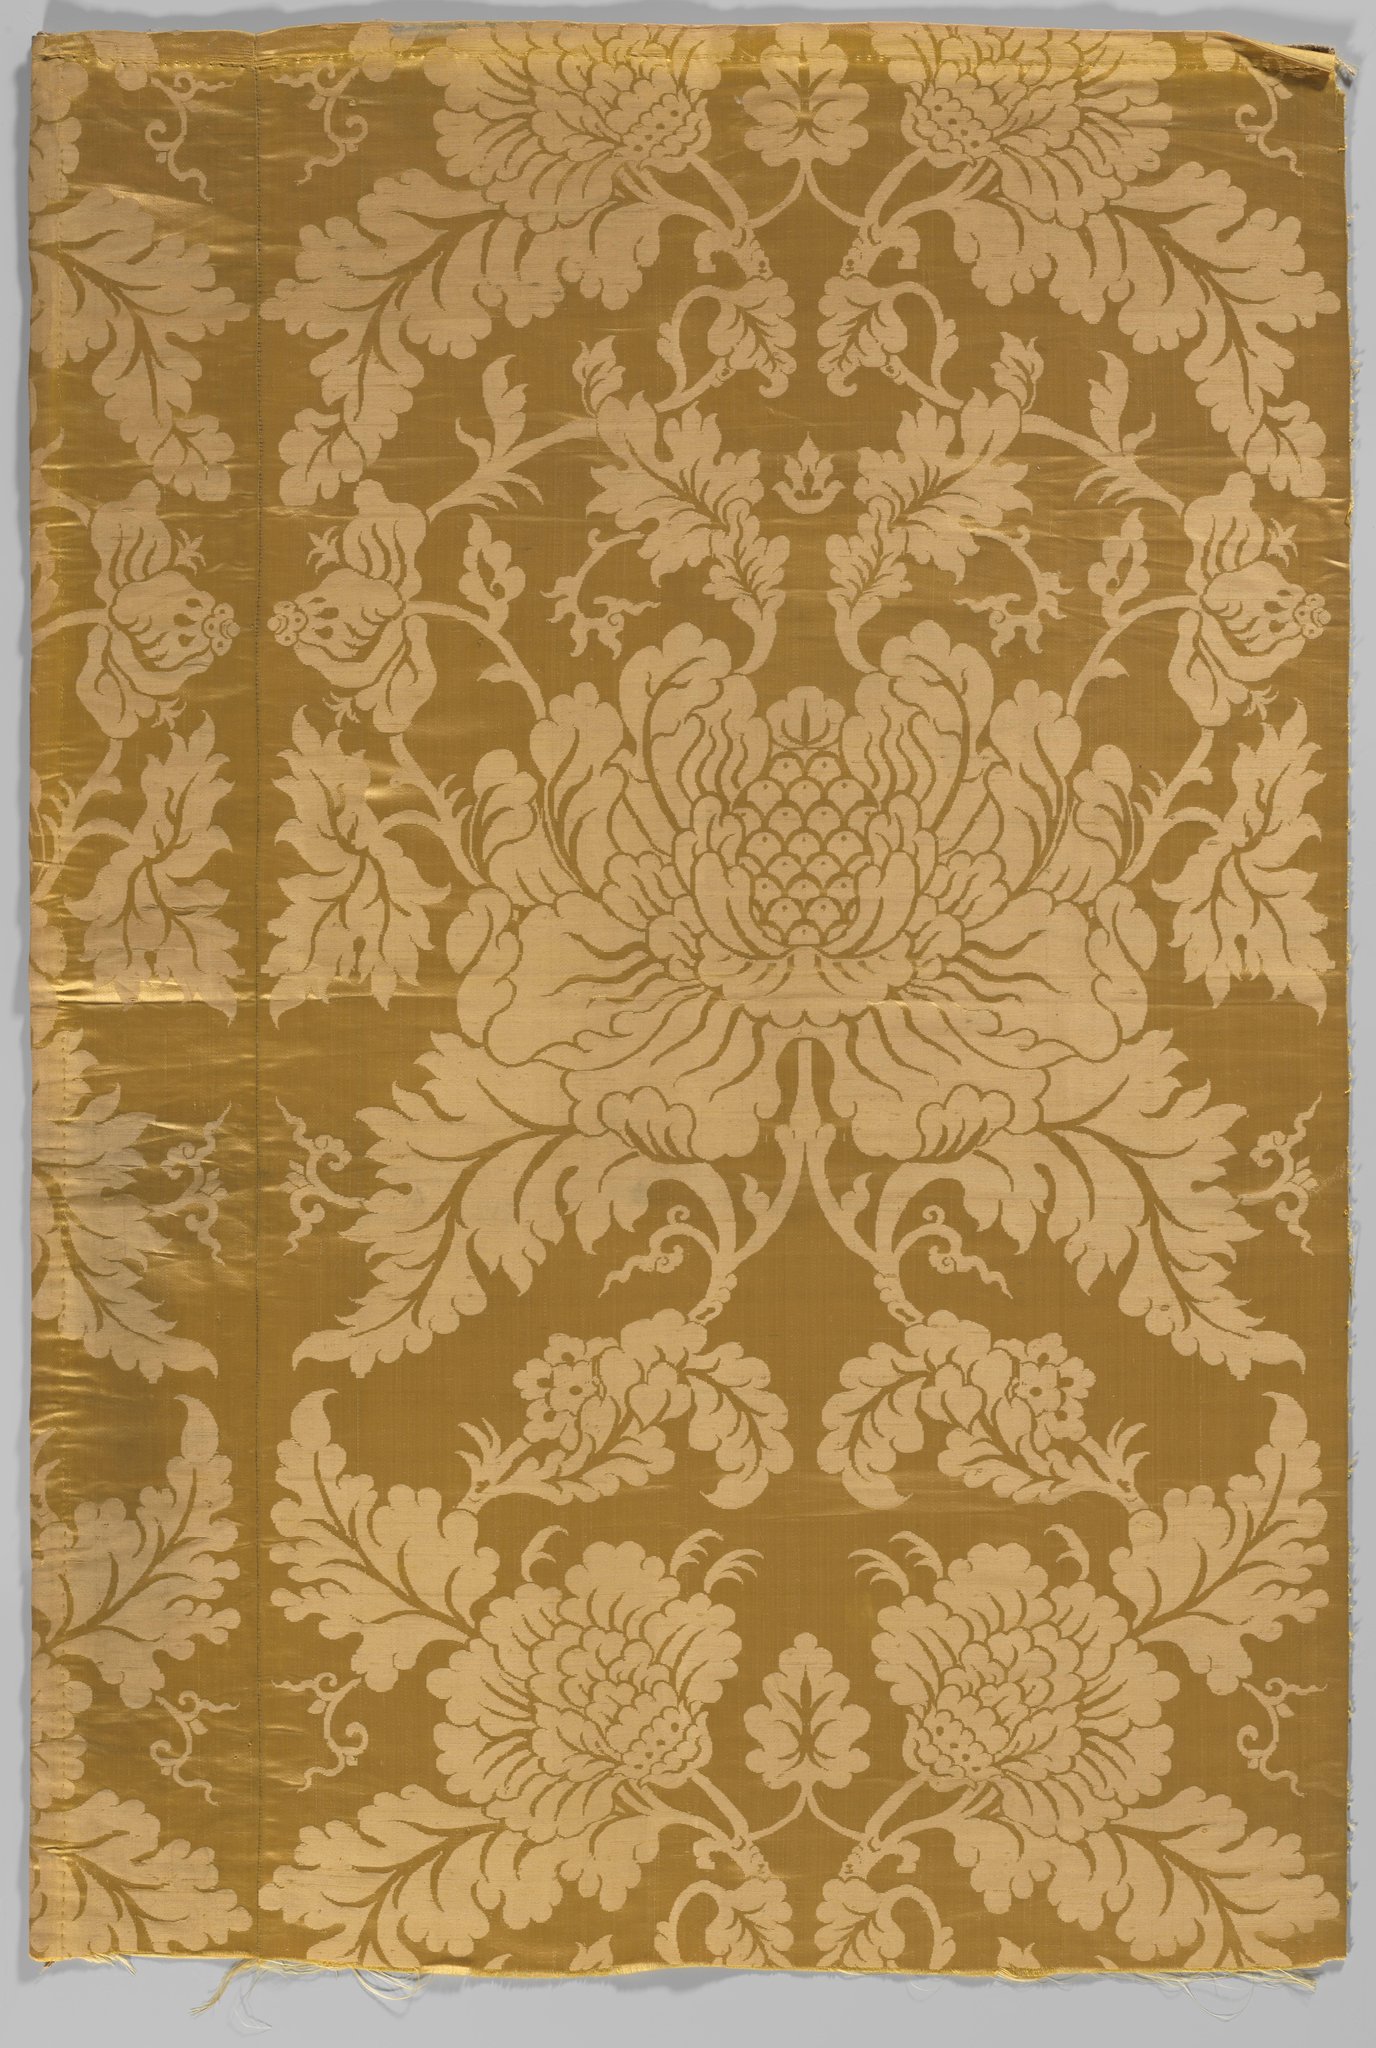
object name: fragment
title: Deel van een wandbespanning van gele zijdedamast met bloemdessin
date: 1700-1725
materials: linen, silk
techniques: damask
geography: france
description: Deel van een wandbespanning van gele zijdedamast waarvan het fond is geweven in satijnbinding. Dessin: symmetrische opbouw van twee opgaande golvende bloem- en bladranken die grote pioenvormige bloemen met een geschubd hart omkaderen. Aan de achterzijde, langs de boven- en rechterrand een strook stofferingslinnen met enkele nagels. Opmerking: de stof is deel van de delen wandbespanning die in 1954 zijn aangekocht op de veiling van A. Mak te Dordrecht. De wandbespanning is afkomstig uit het pand Voorstraat 140, Dordrecht.